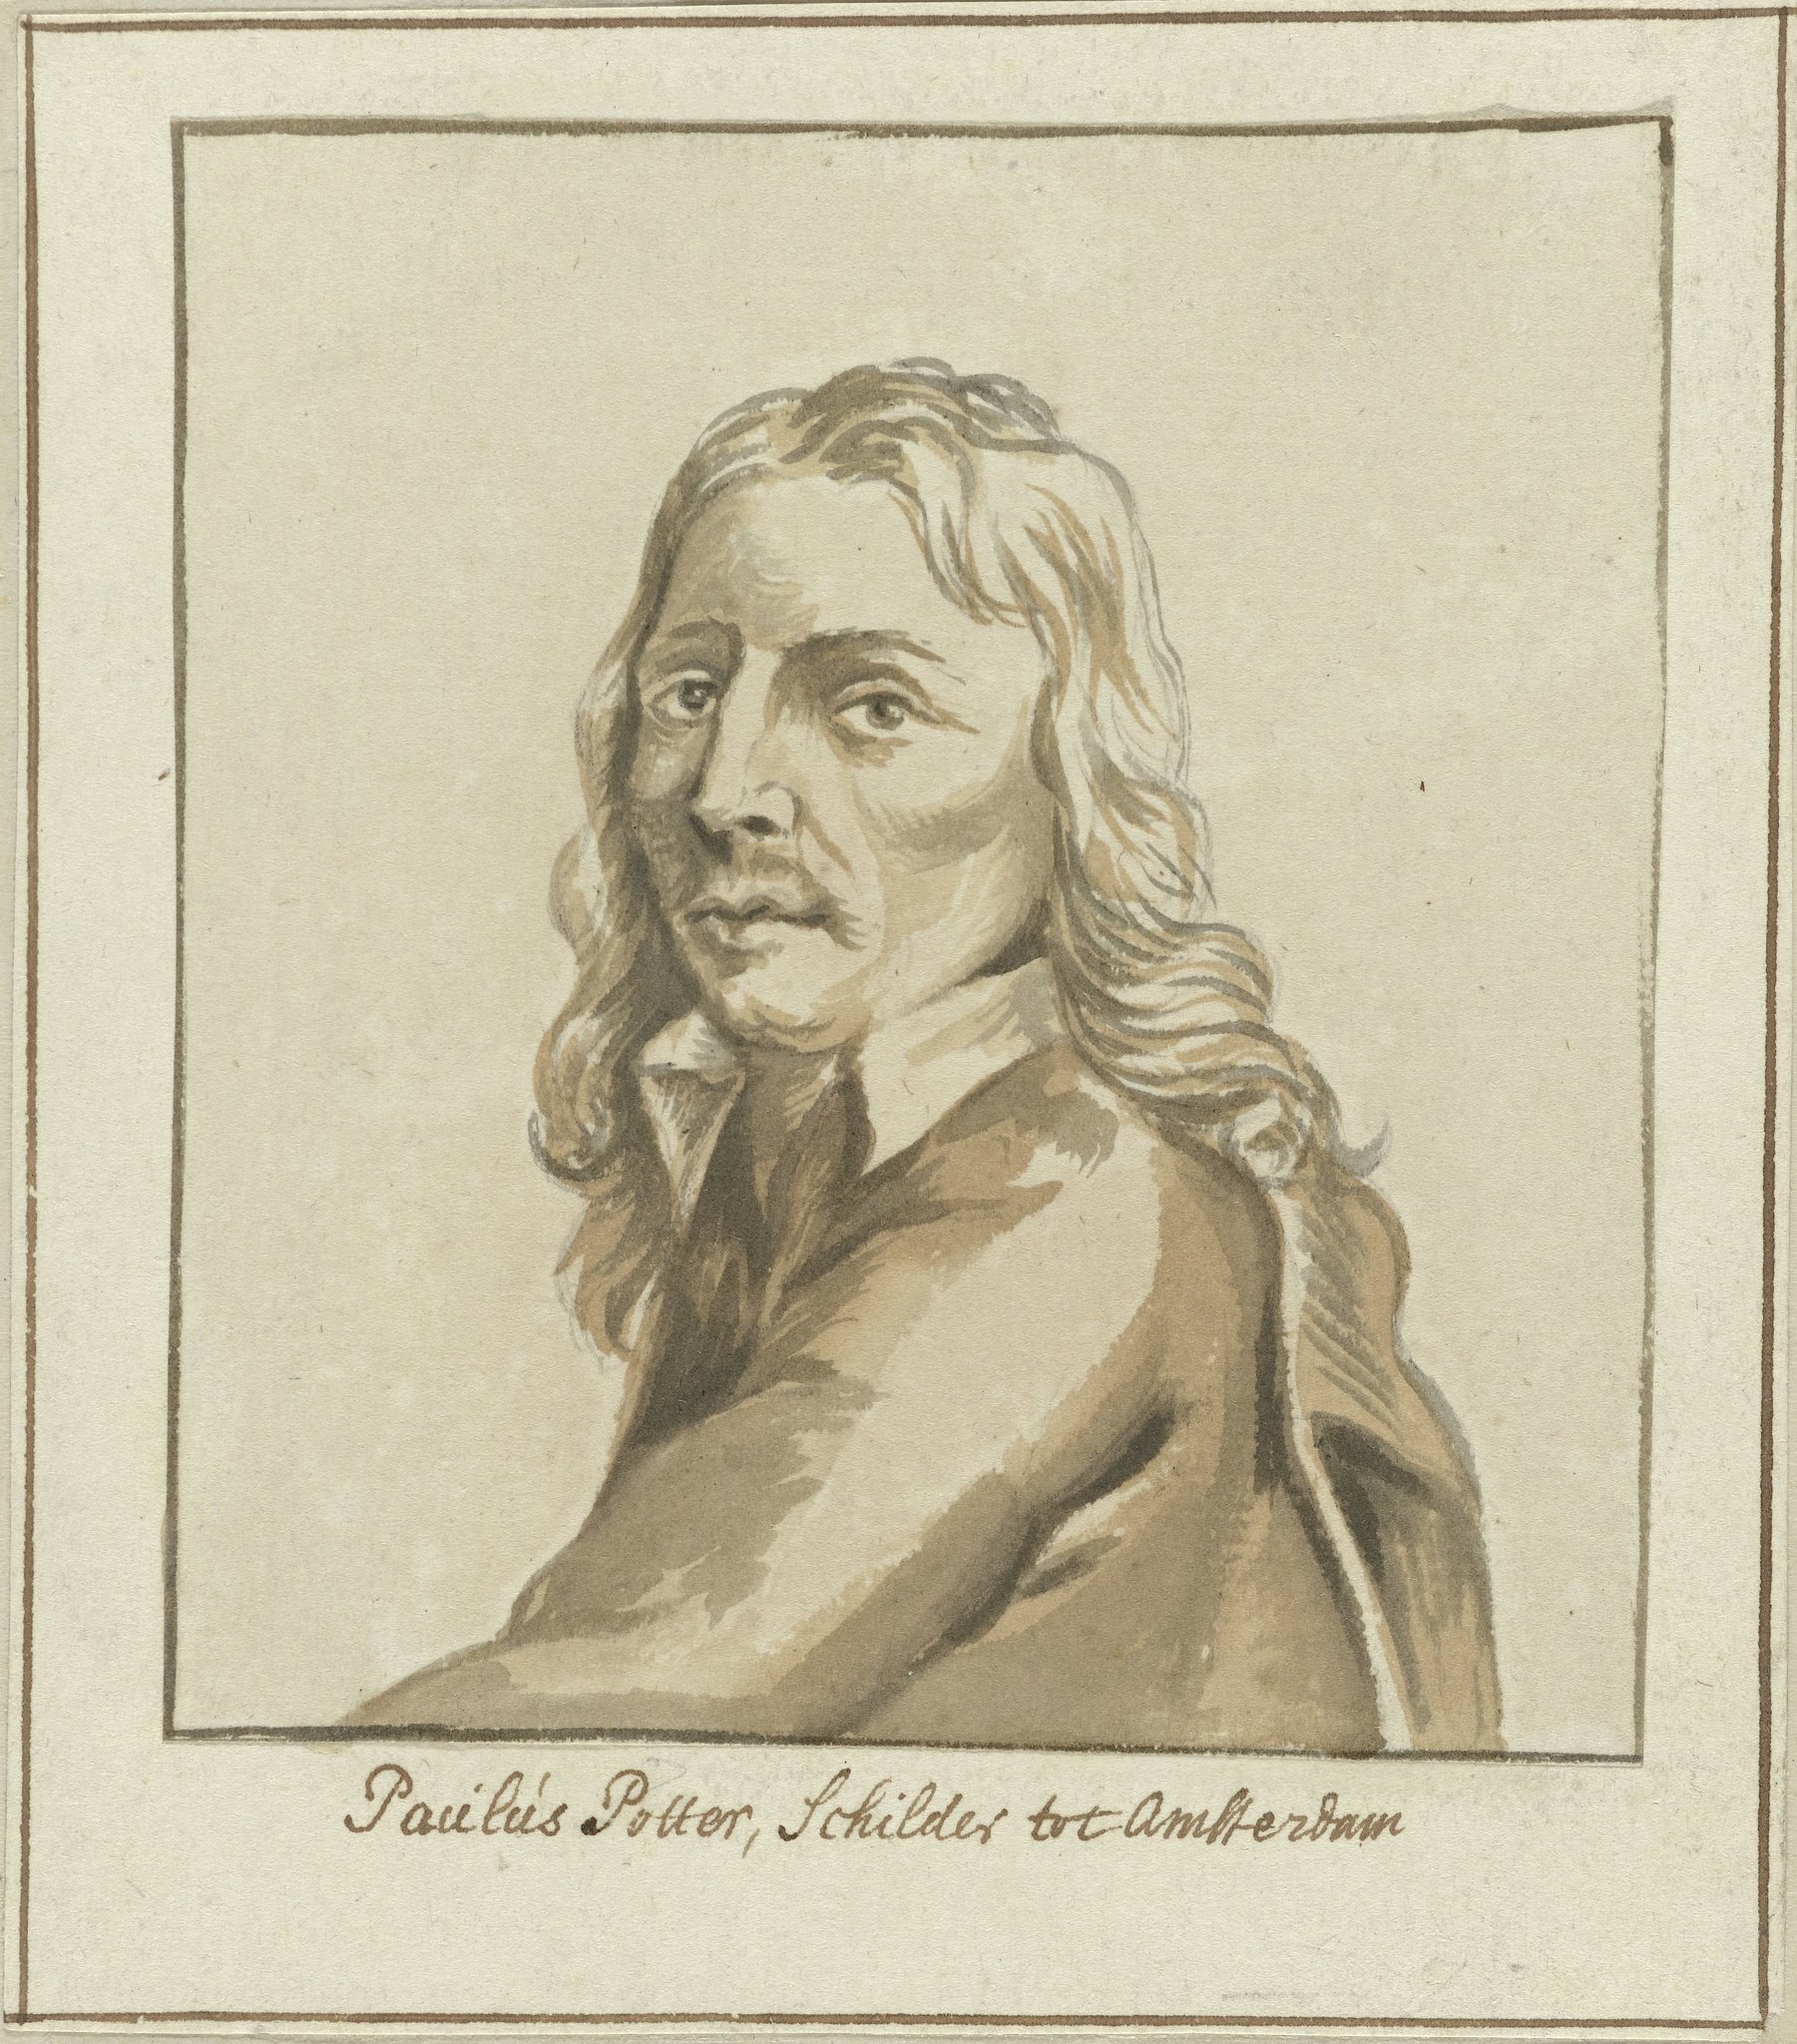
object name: drawing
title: Portret van Paulus Potter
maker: abraham rademaker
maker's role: draughtsman, print maker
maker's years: 1676-1735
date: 1686-1735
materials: paper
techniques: brush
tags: enkhuizen, amsterdam, painter, print maker, draughtsman, paulus potter, historical persons, portrait, self-portrait of painter, portrait, self-portrait of artist